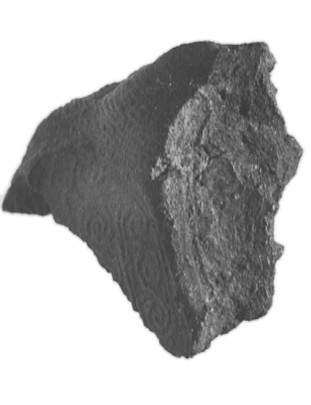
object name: sealing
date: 2030-1640 BCE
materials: clay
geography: egypt